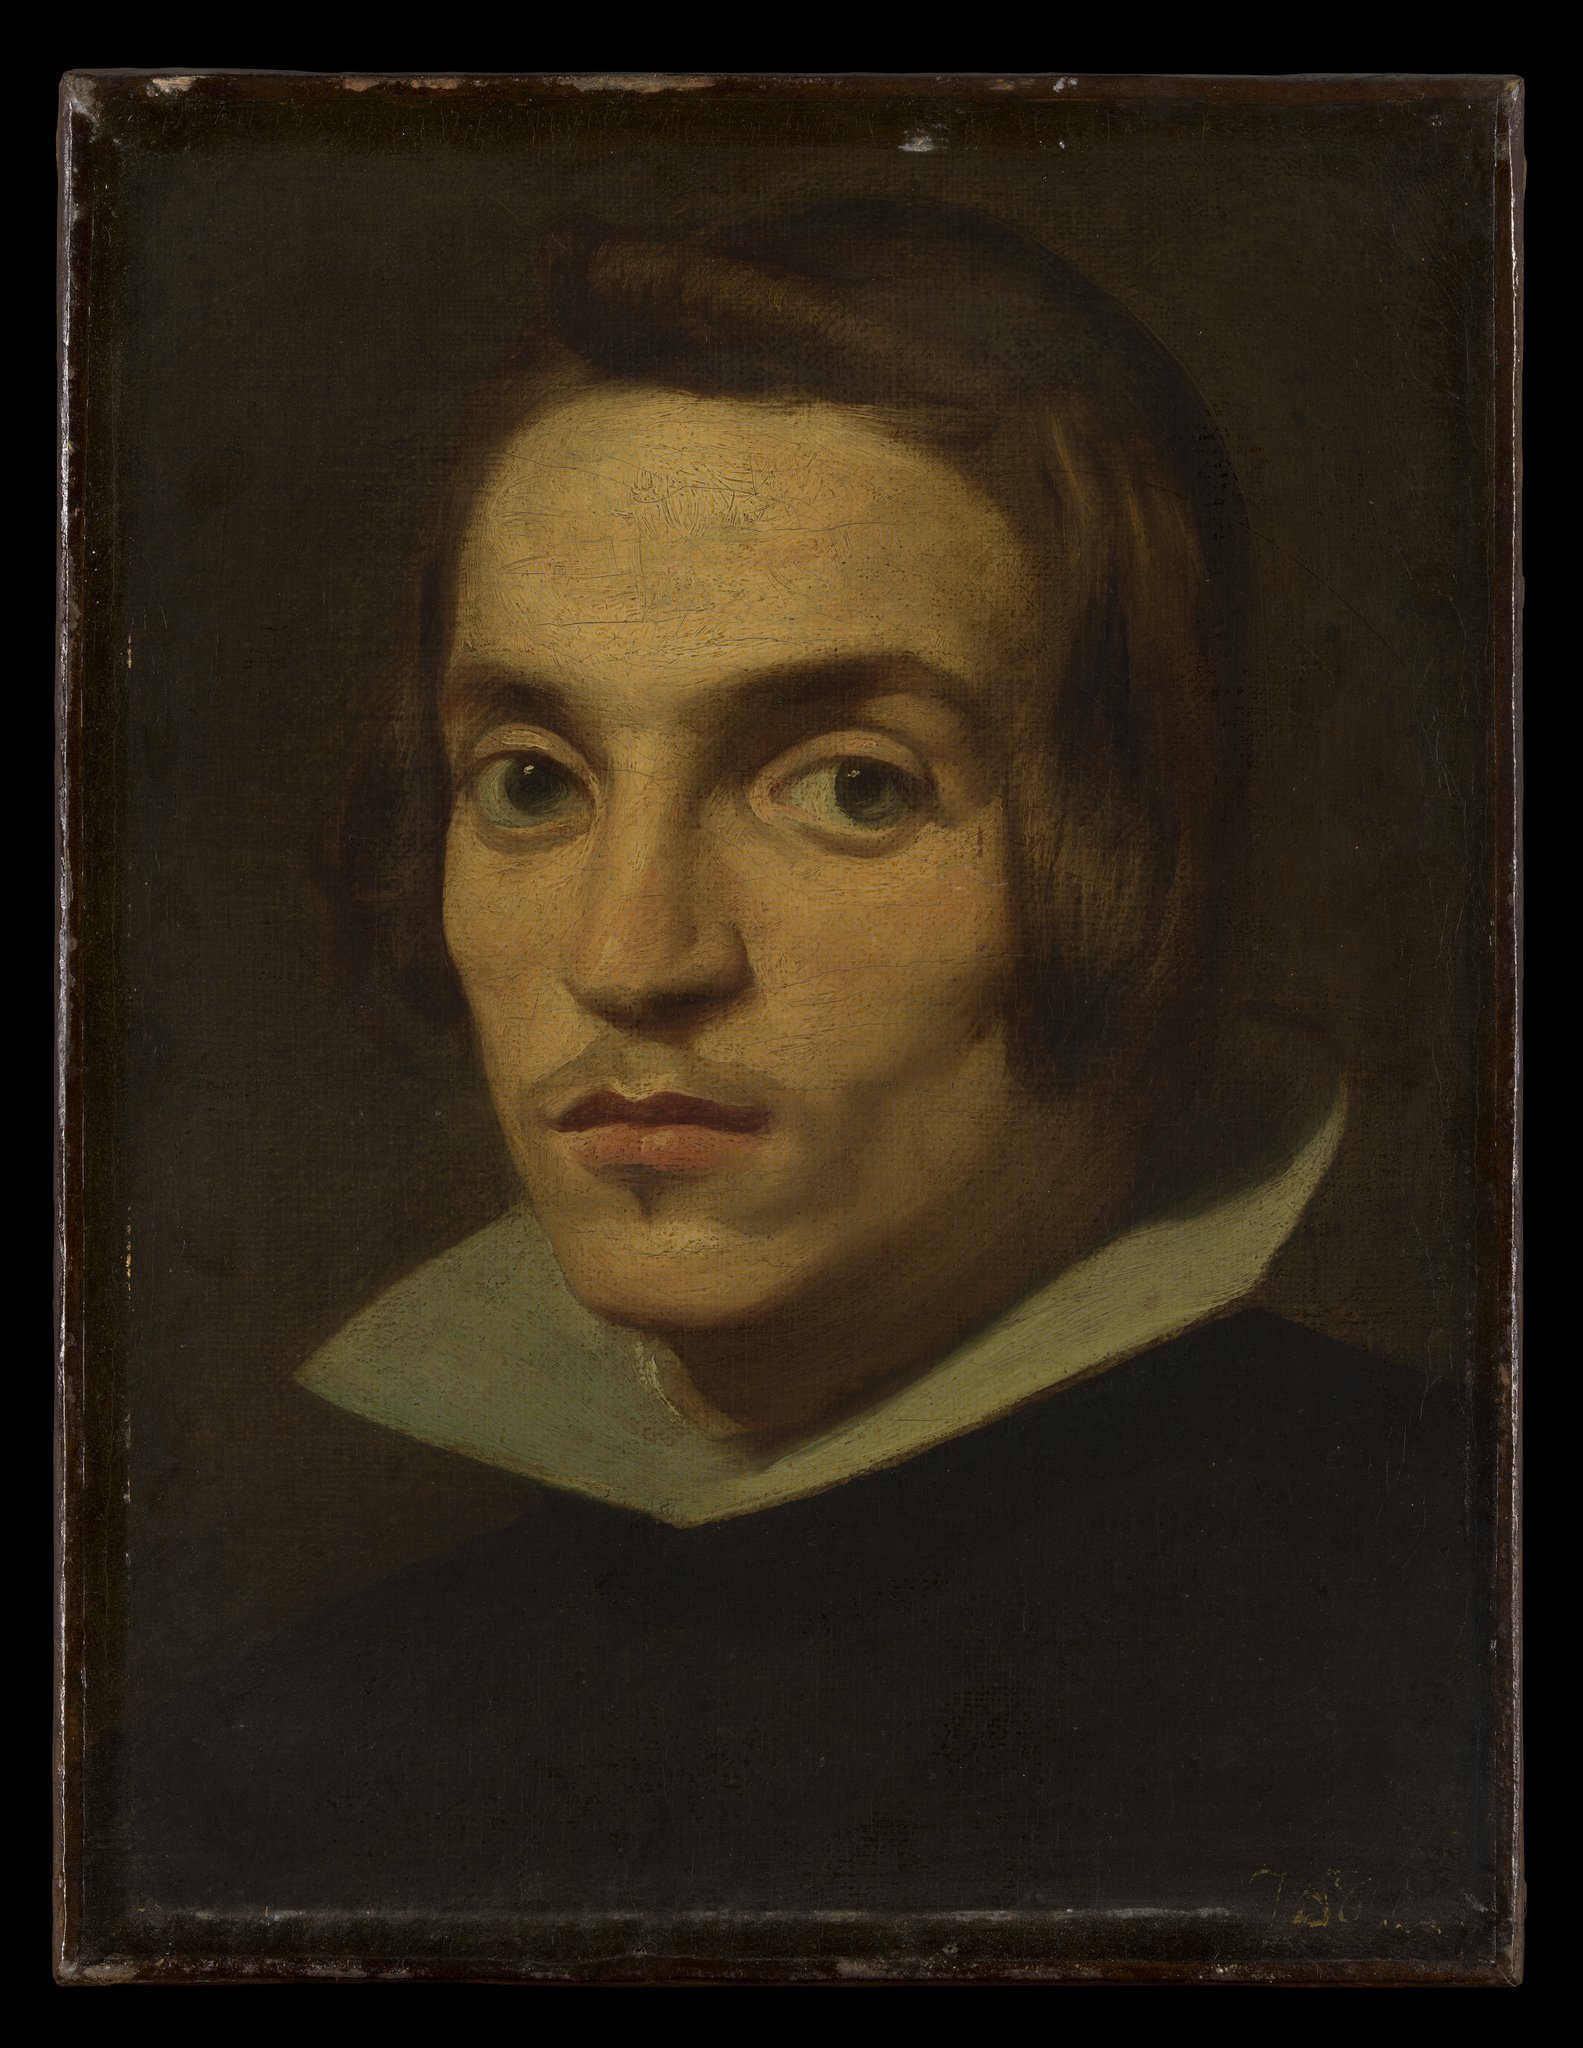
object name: painting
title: Head of a Man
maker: spanish (castilian) painter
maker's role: artist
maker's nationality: spanish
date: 1630-1669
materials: canvas, oil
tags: men,portraits